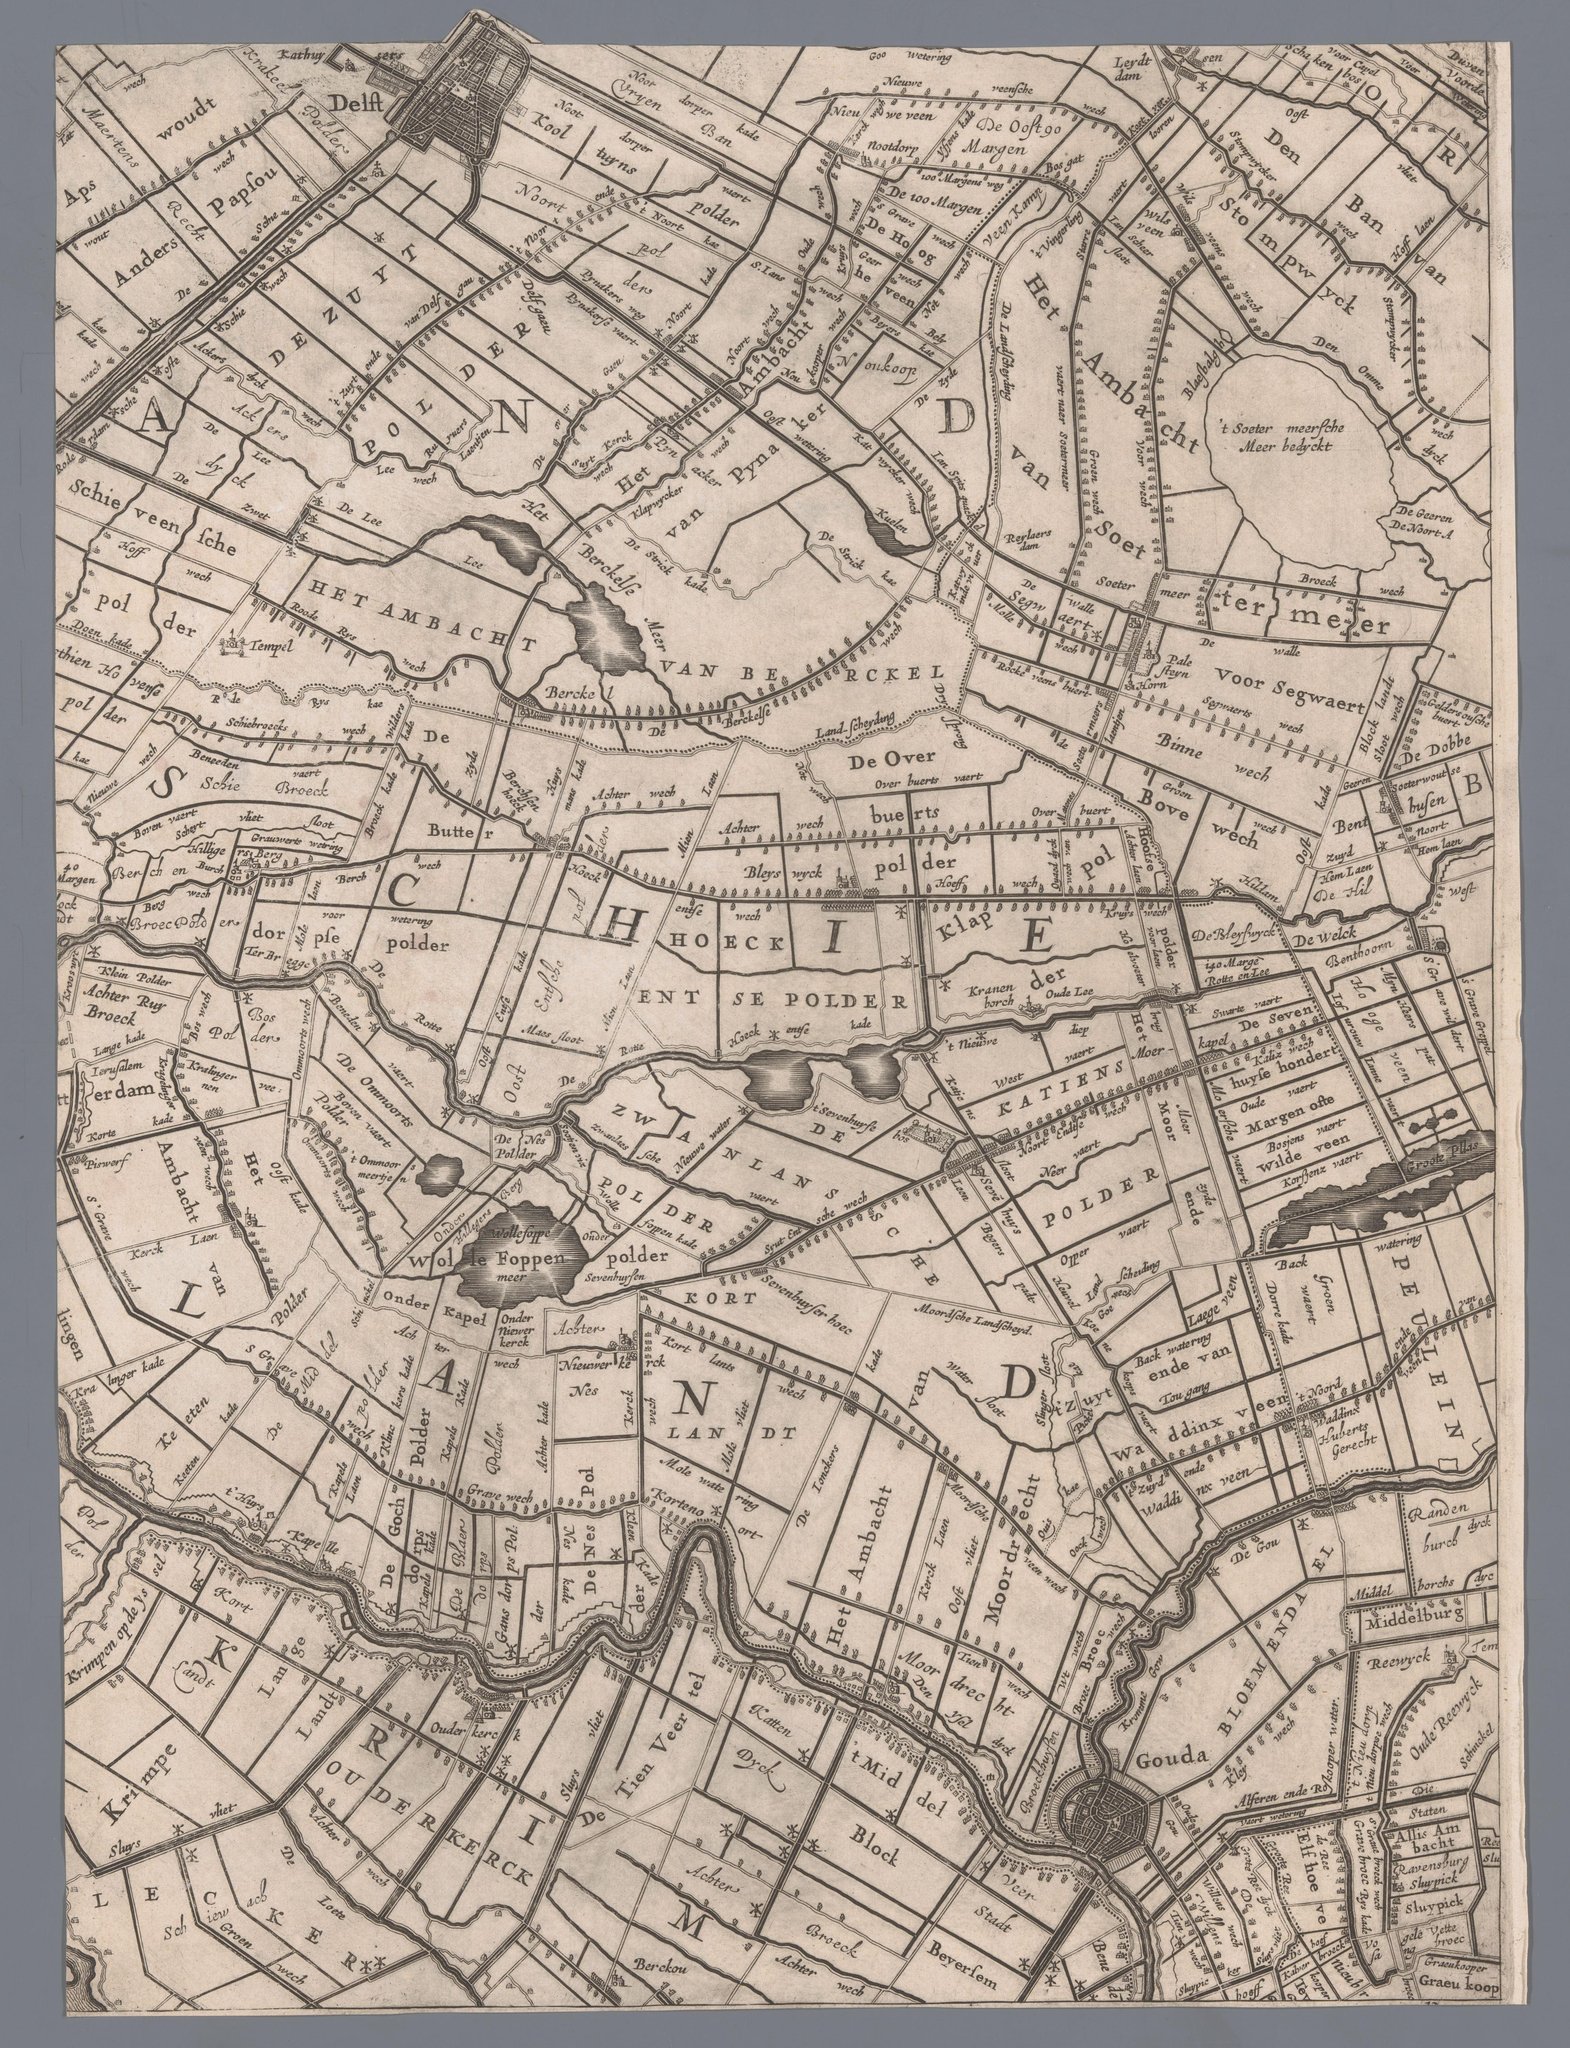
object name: print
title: Kaart van het Graafschap Holland en Utrecht (plaat 13)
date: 1639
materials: paper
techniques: engraving, etching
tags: maps, atlases, delft, gouda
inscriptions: collector's mark: Lugt 2228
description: Onderdeel van een kaart samengesteld uit 40 bladen. Waarschijnlijk gaat het om de grootste kaart van Holland uit de zeventiende-eeuw. De kaart is uitgegeven in verschillende edities, deze kaart uit 1639 is de eerste editie.